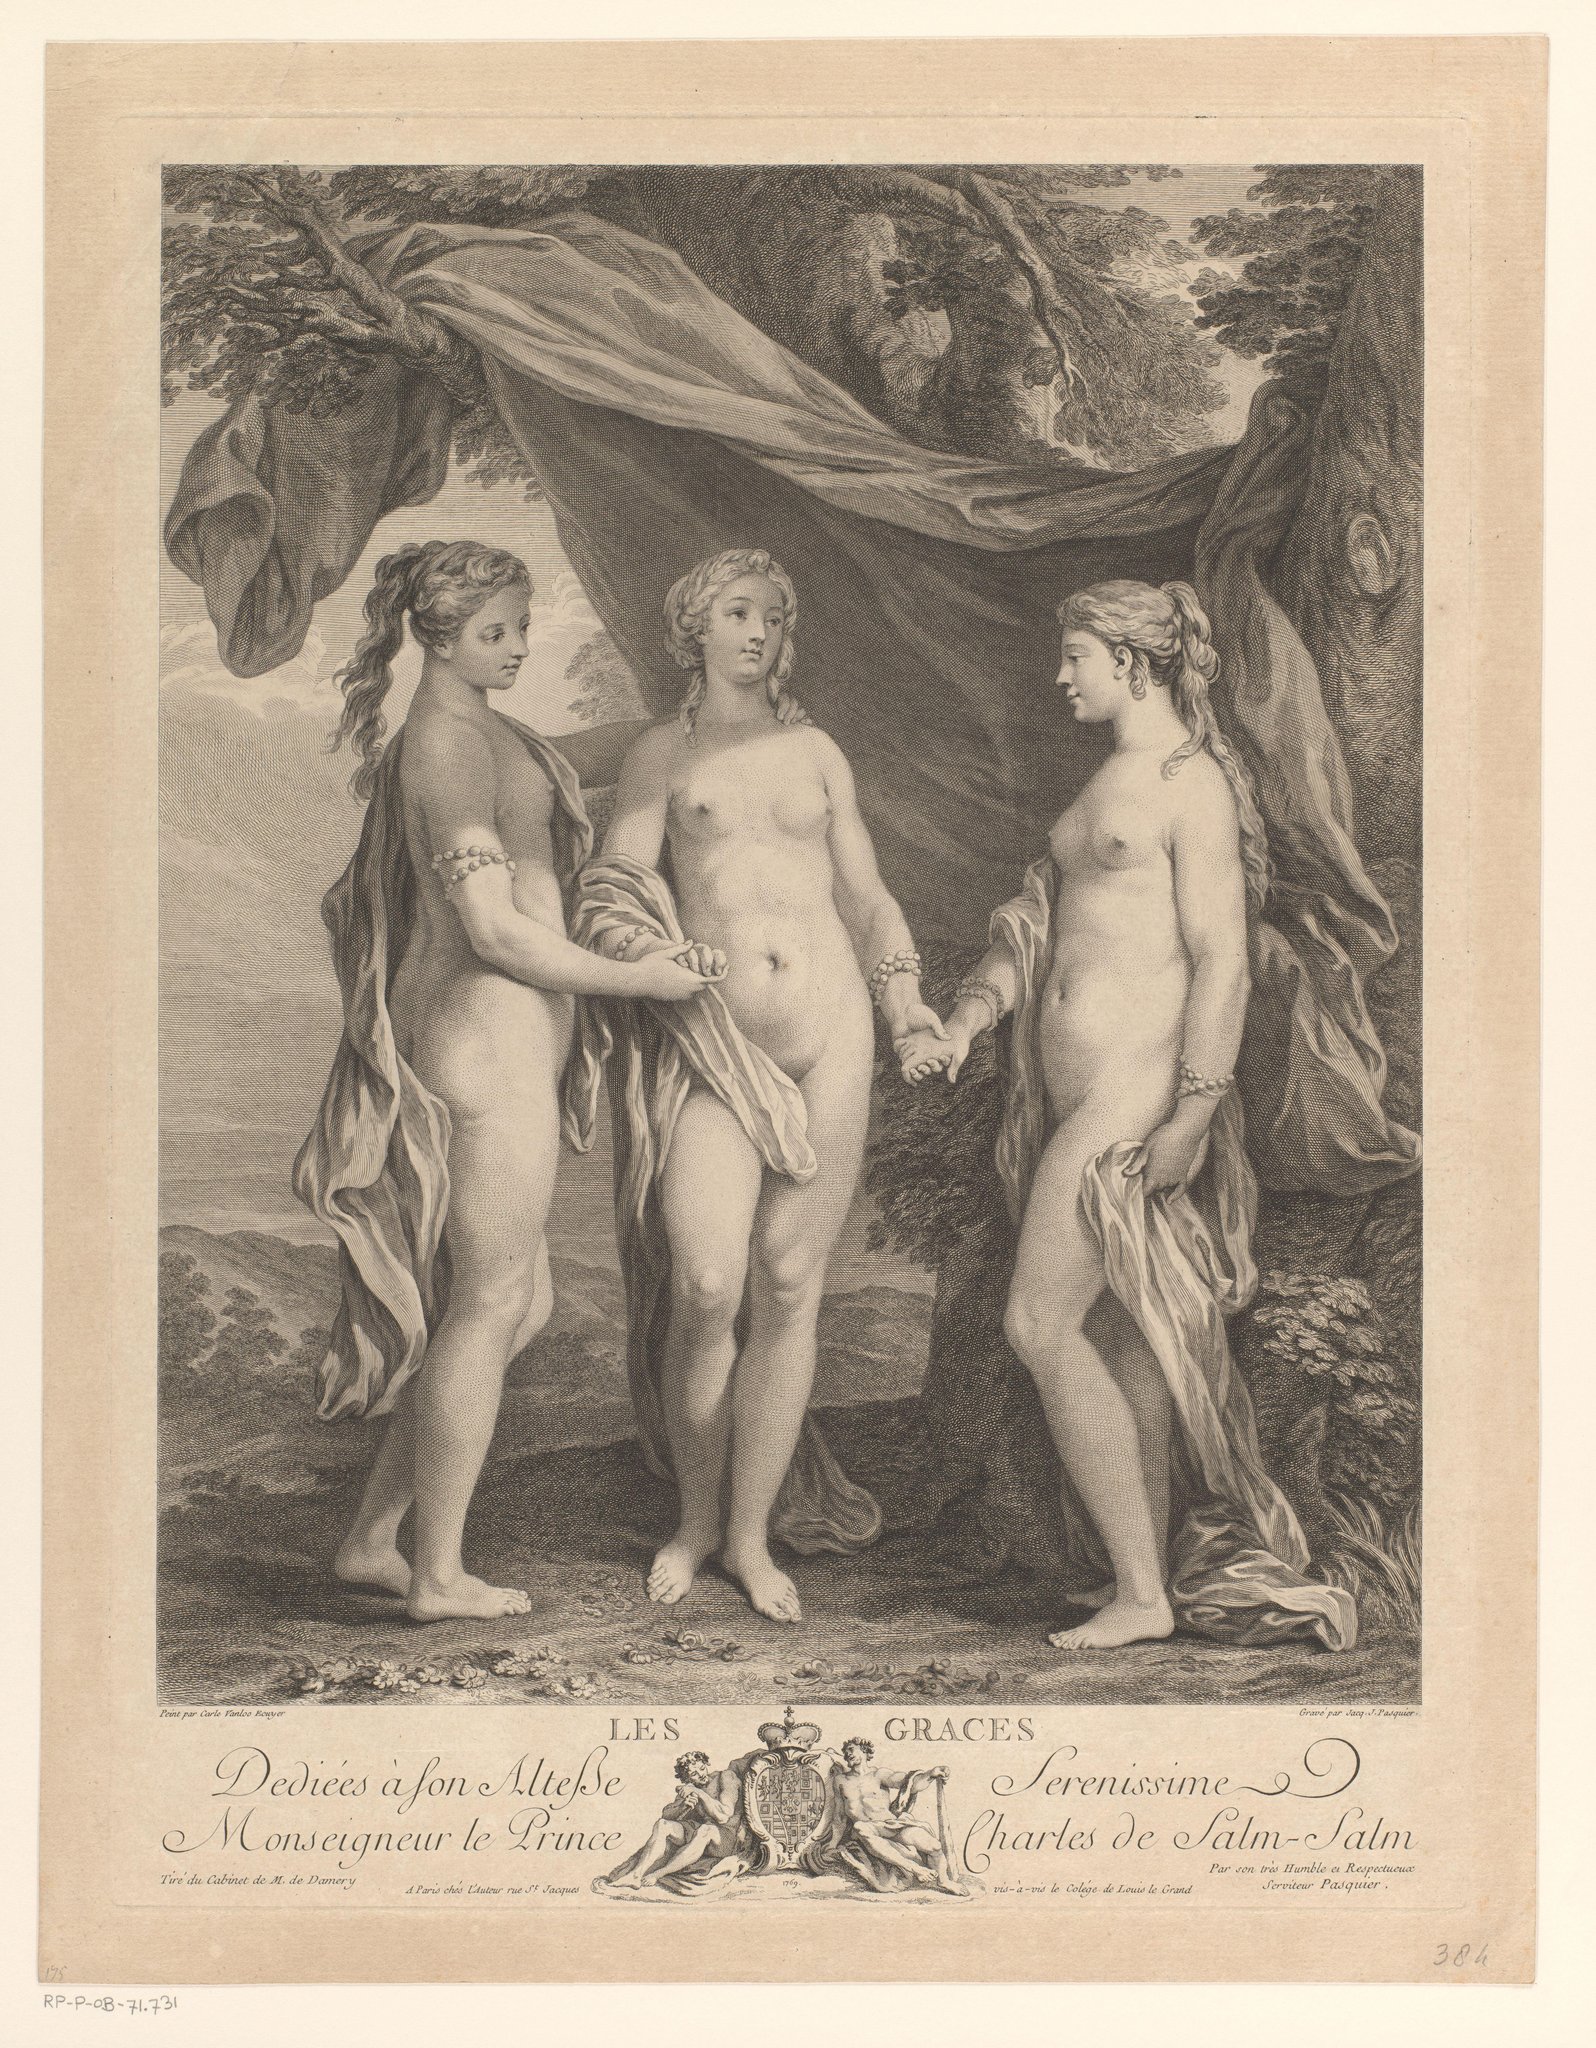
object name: print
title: Les Graces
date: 1685-1785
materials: paper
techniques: engraving, etching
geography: paris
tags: graces (charites), generally three in number; 'gratie' (ripa)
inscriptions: collector's mark: Lugt 2228